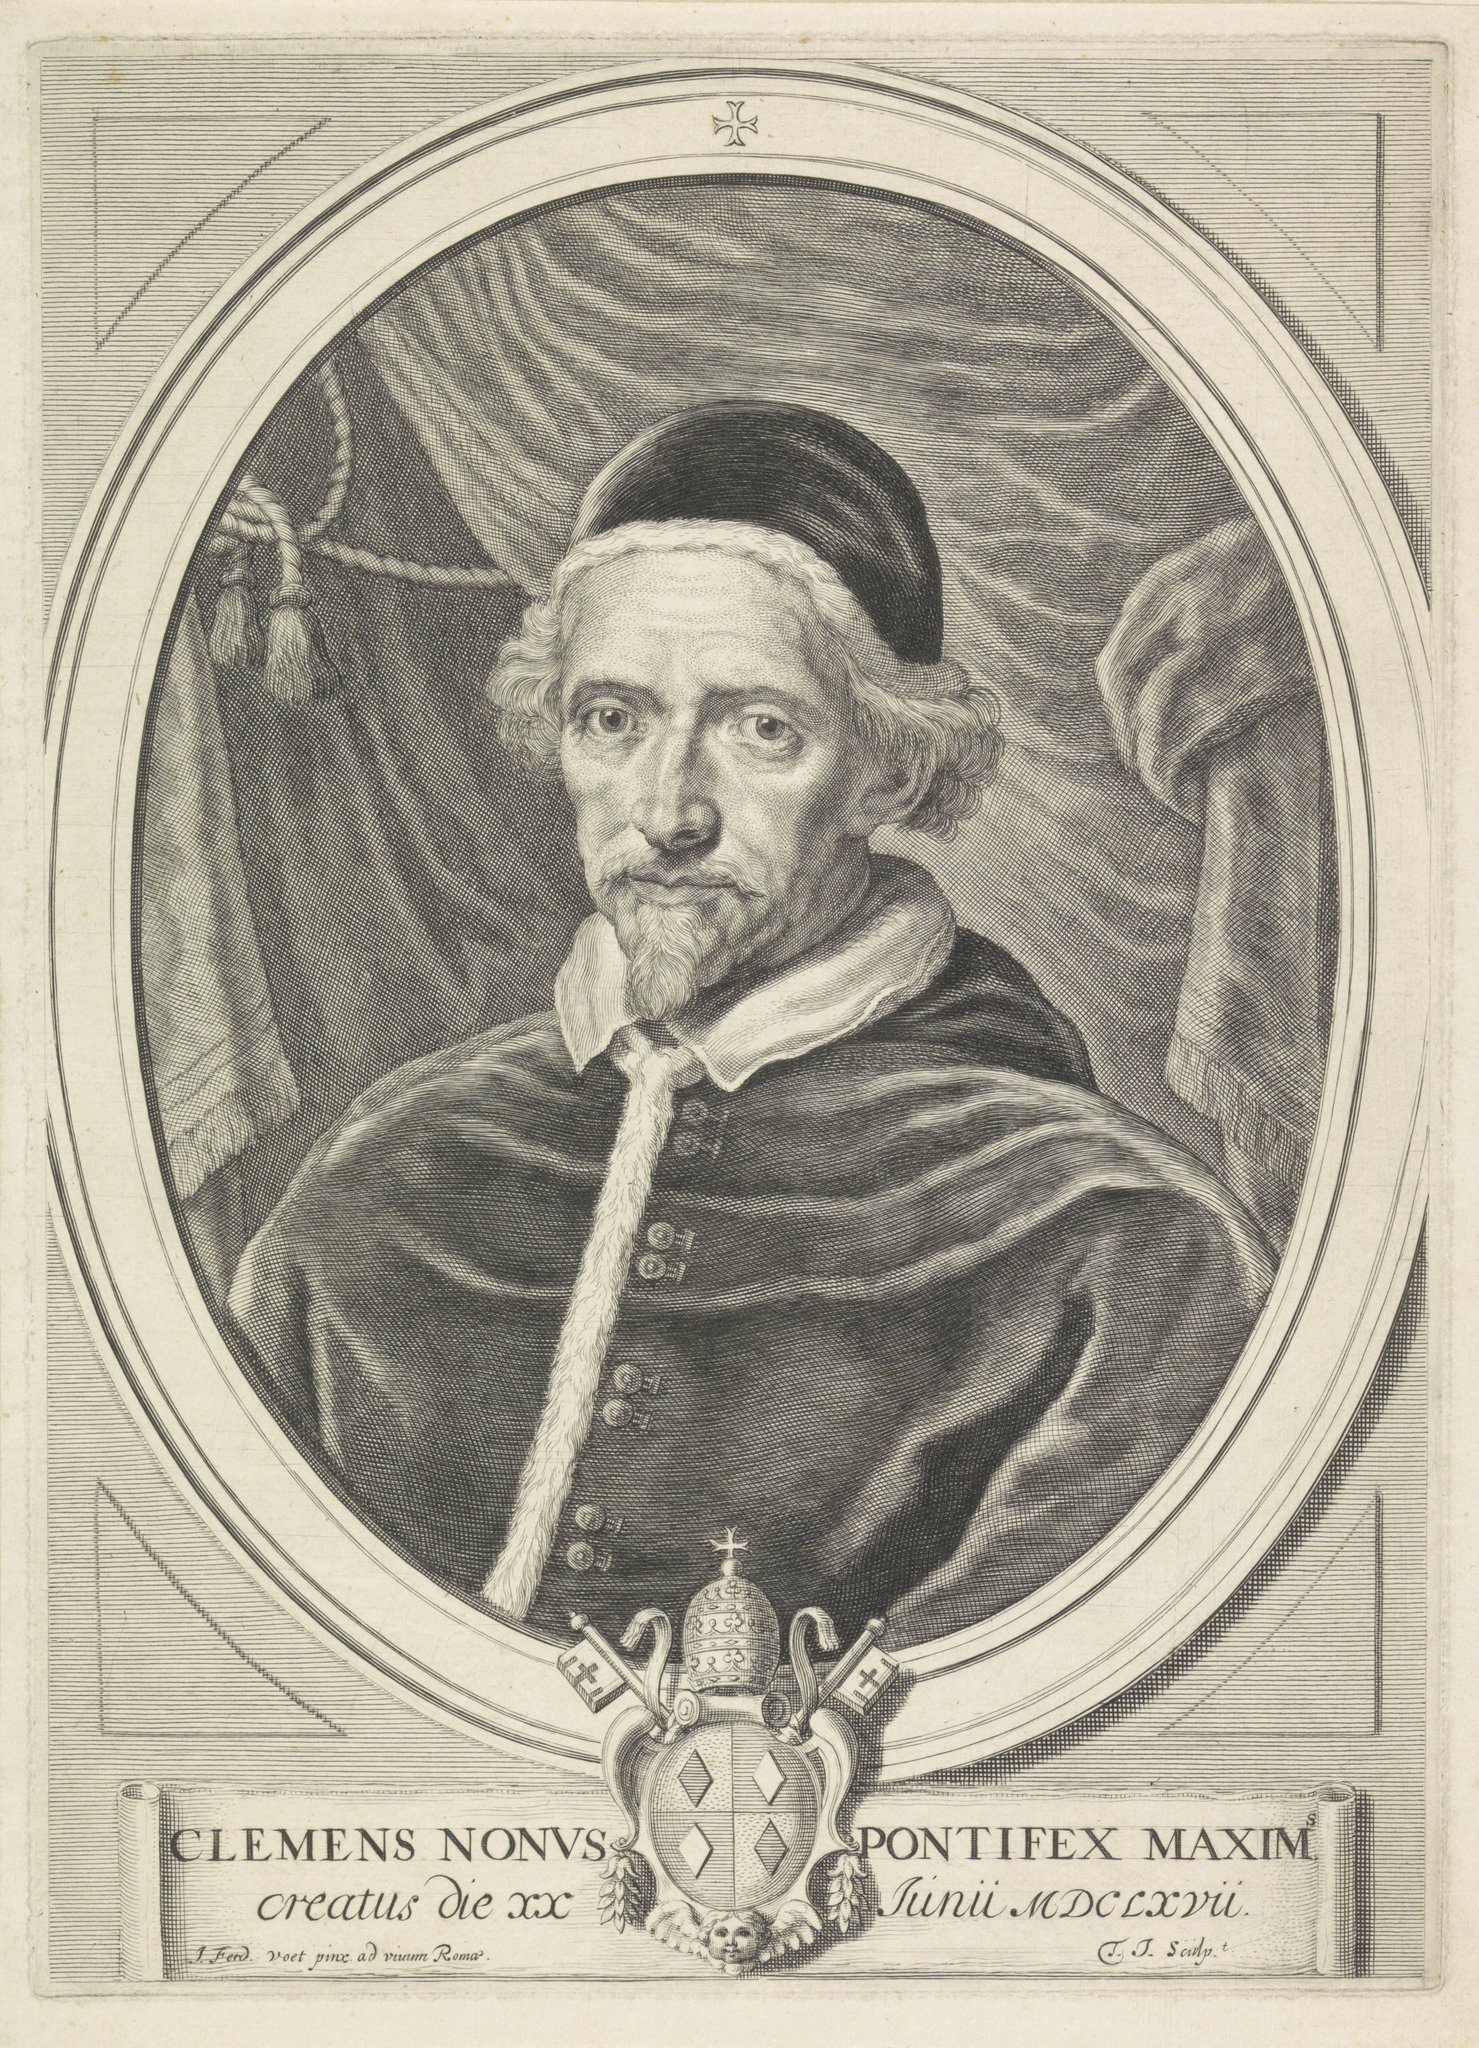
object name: print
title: Portret van paus Clemens IX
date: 1667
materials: paper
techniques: engraving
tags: clemens ix, pope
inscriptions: collector's mark: Lugt 2228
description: Paus Clemens IX, gehuld in het pauselijk gewaad, het hoofd getooid met een camauro. Onderaan zijn pauselijk wapen.